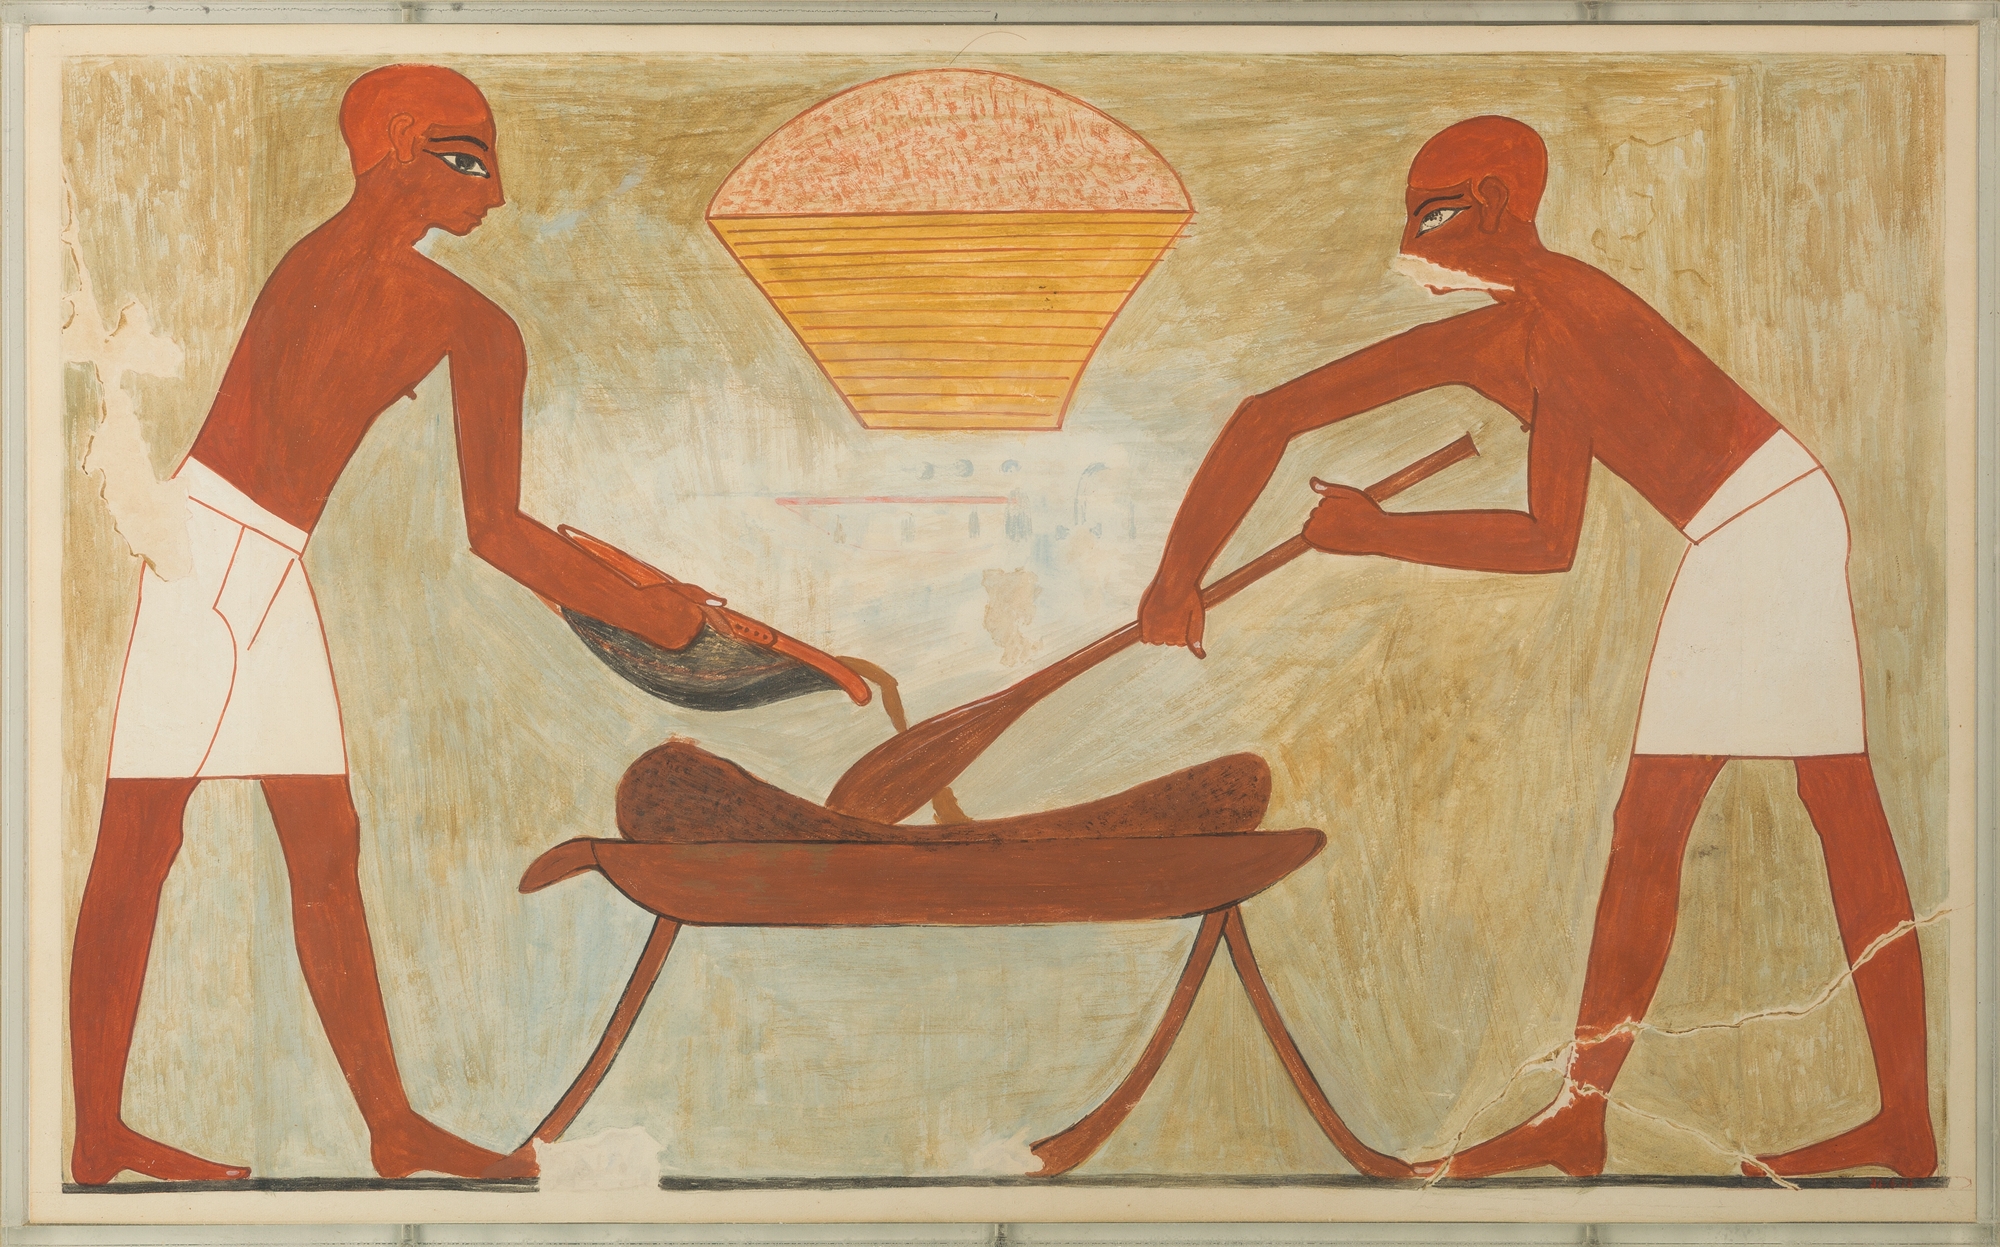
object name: facsimile, rekhmire tt 100, cooking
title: Preparing Dough, Tomb of Rekhmire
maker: nina de garis davies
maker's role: artist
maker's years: 1881-1965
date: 1504-1425 BCE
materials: ink, paint, paper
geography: egypt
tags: food,men,daily life,working,cooking,baskets,rekhmire-exhibition